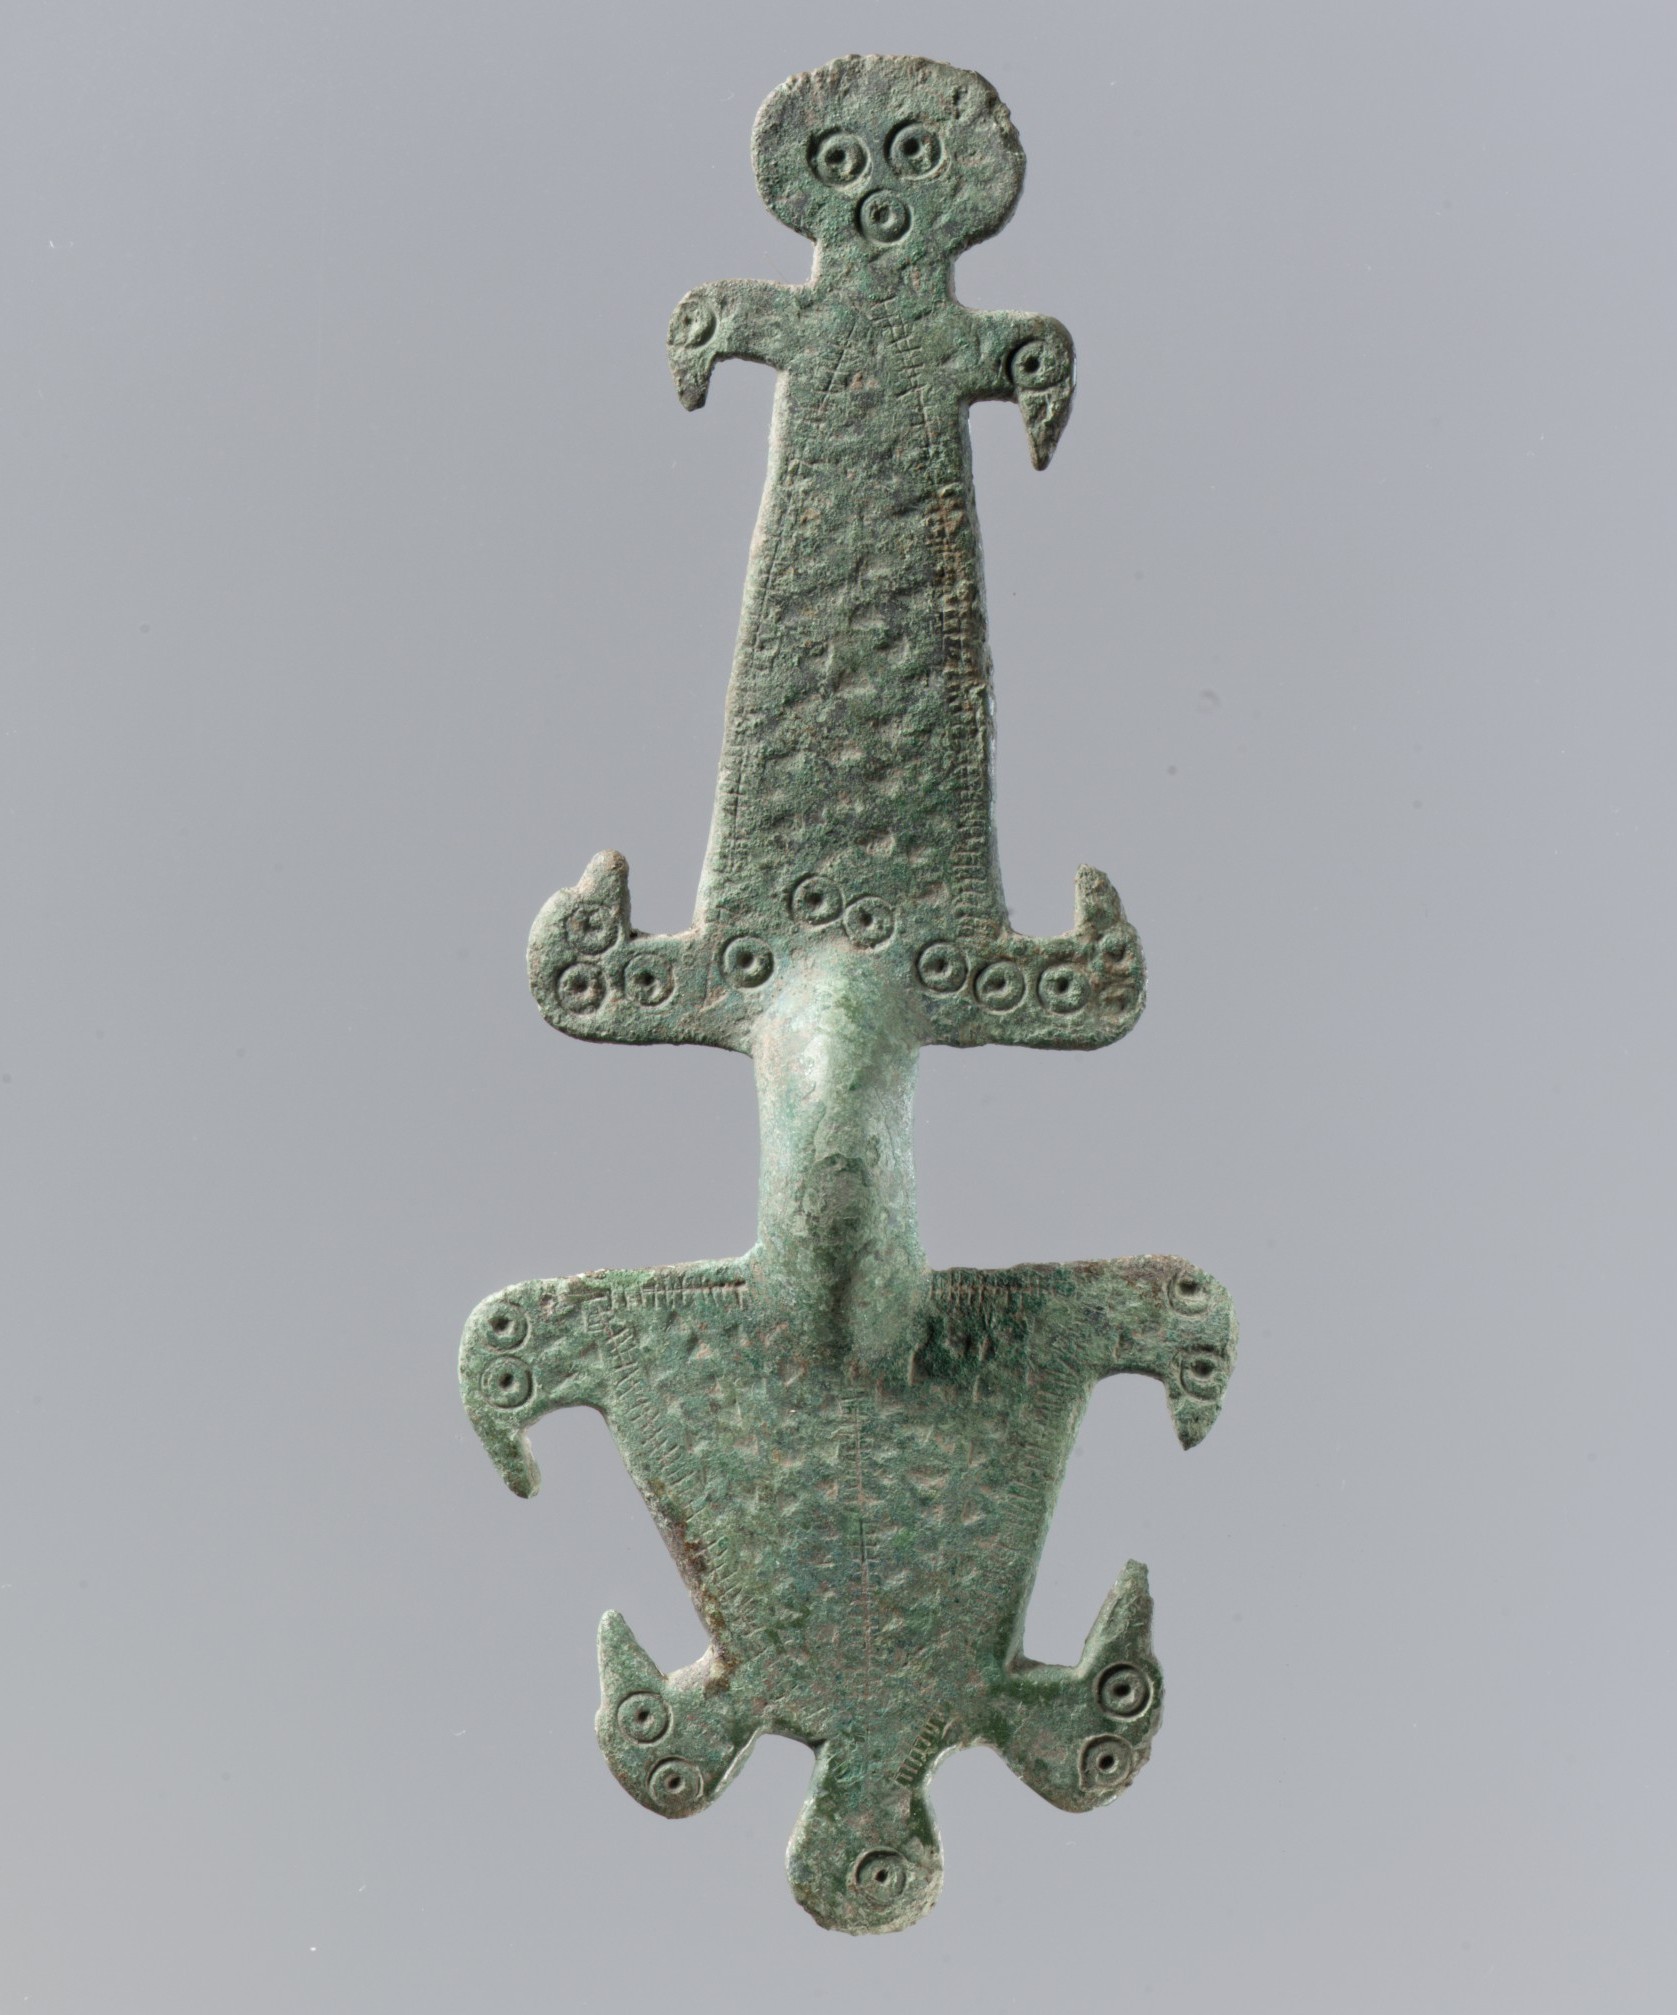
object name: brooch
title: Bow Brooch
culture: visigothic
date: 550-600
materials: copper alloy